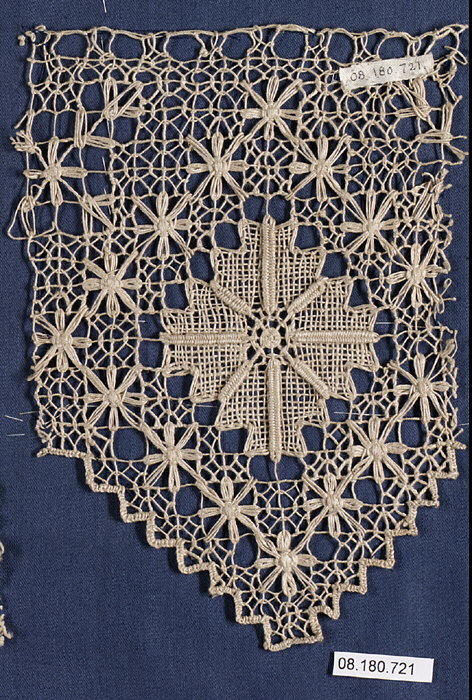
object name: fragment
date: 1801-1900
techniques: embroidery